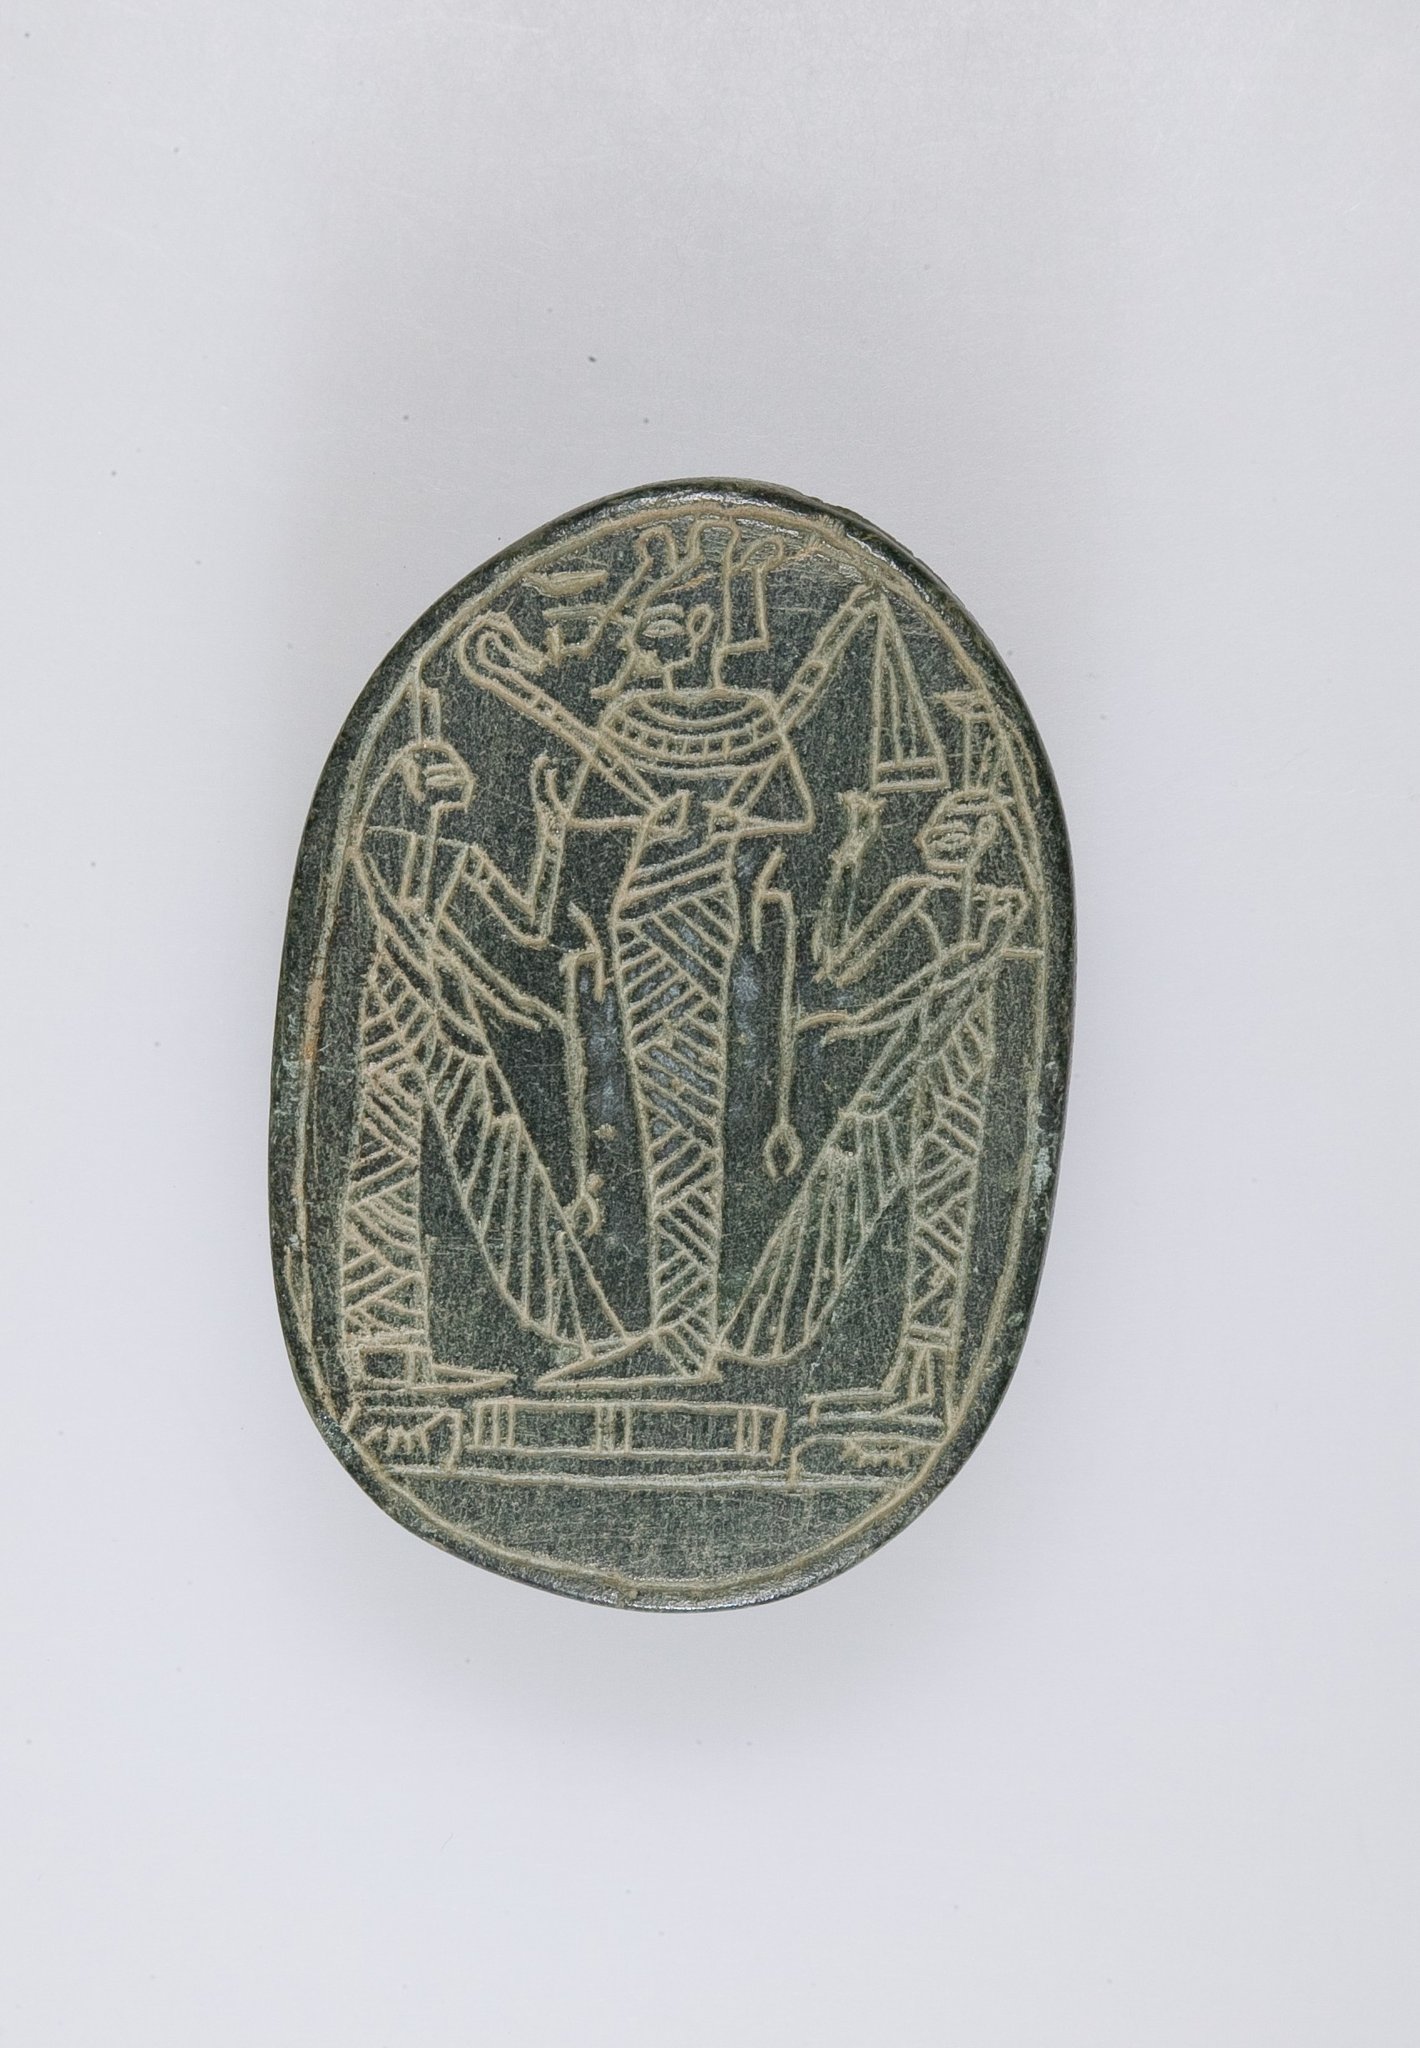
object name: heart scarab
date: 1295-1070 BCE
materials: stone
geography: egypt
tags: human figures,scarabs